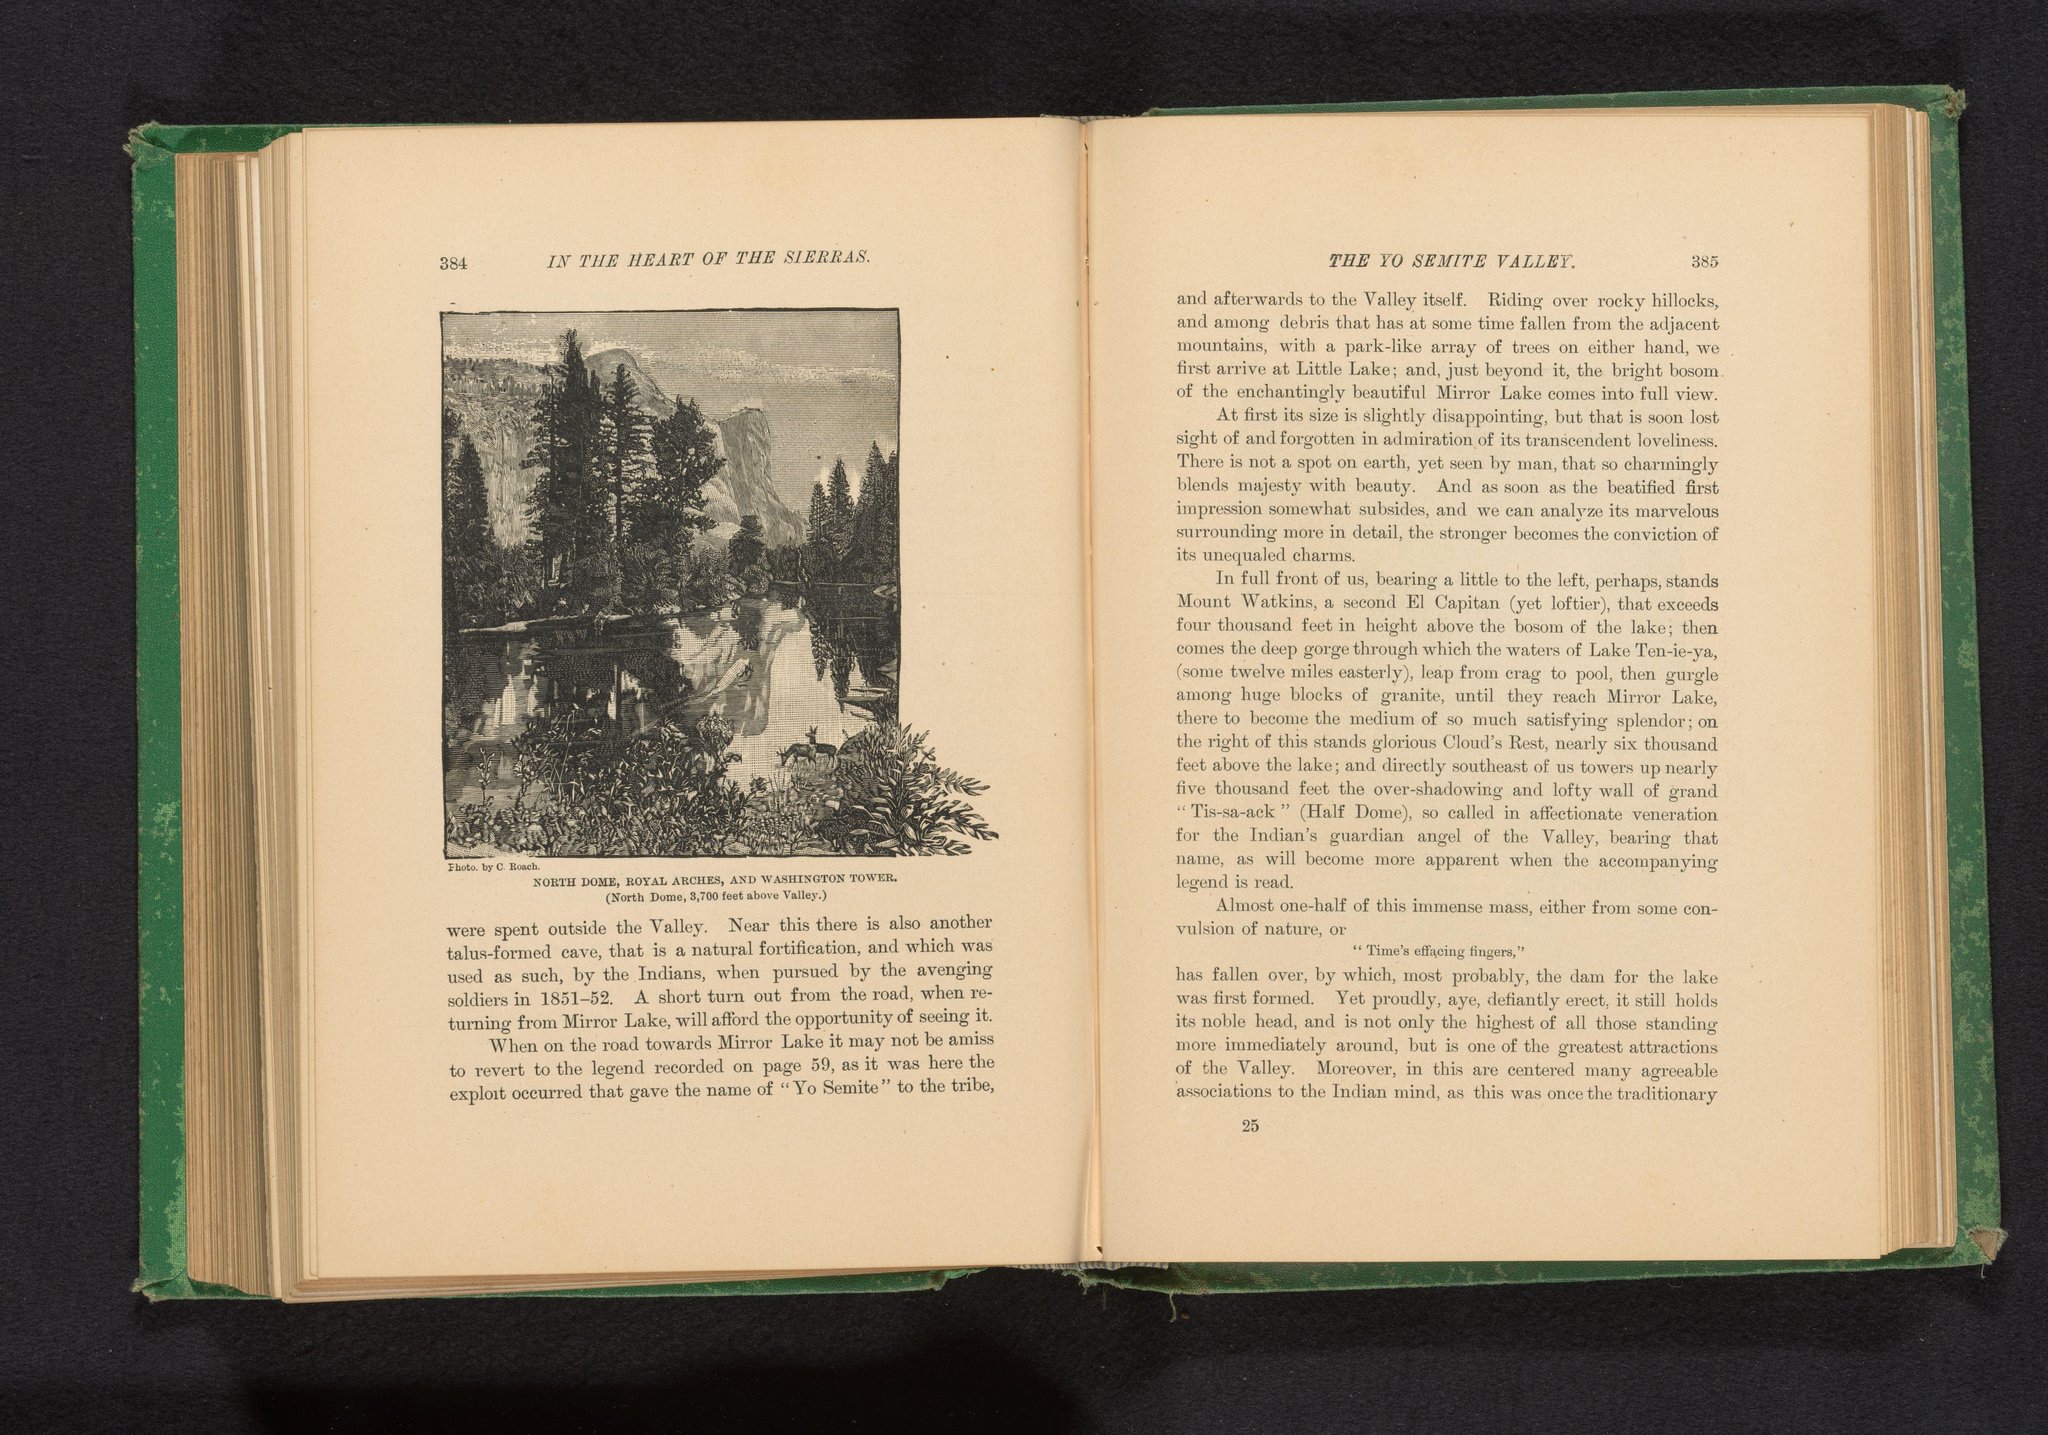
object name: page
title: North Dome, Royal Arches, and Washington Tower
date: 1881-1886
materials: paper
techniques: printing block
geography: yosemite valley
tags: lake, forest, wood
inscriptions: inscription: ‘(North Dome, 3,700 feet above Valley.)’